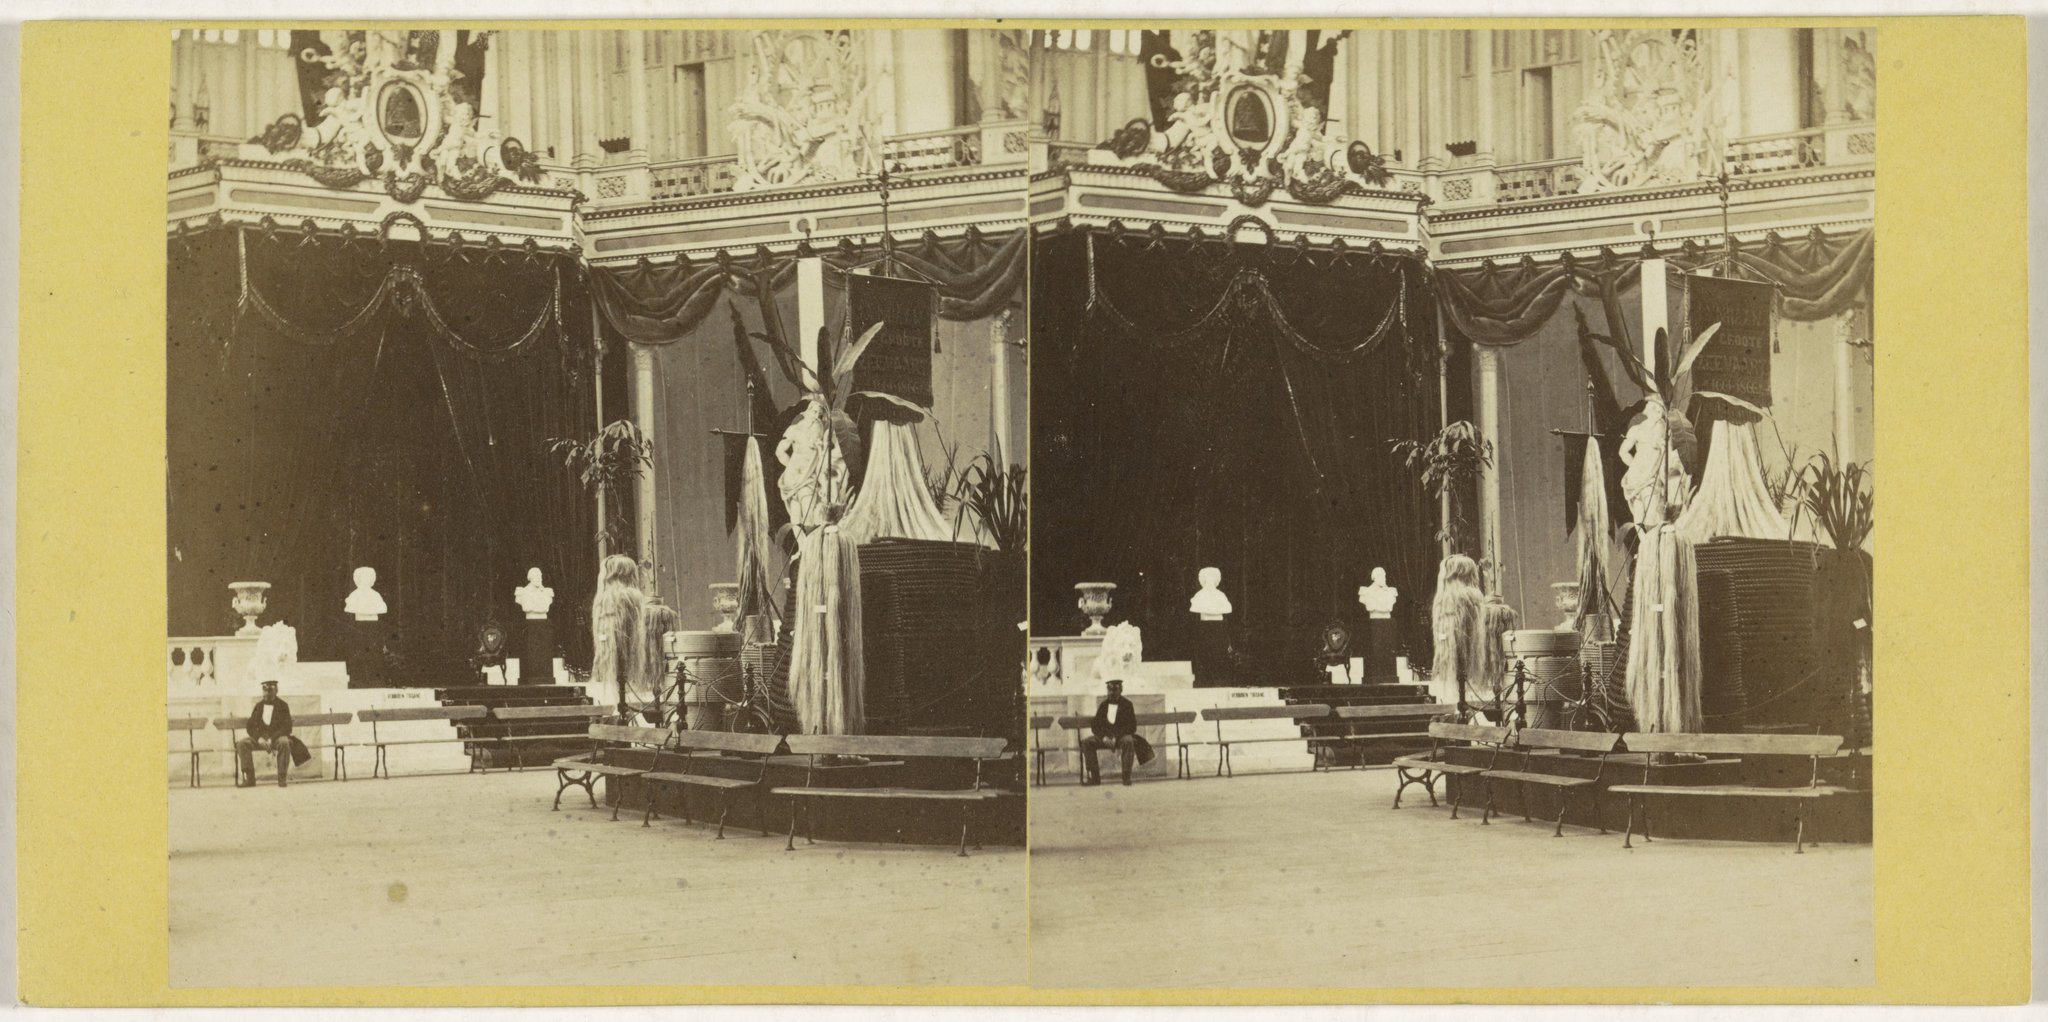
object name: stereograph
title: Bustes en andere objecten bij de Tentoonstelling voor Nationale Nijverheid en Kunst in het Paleis voor Volksvlijt, Amsterdam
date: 1866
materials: cardboard, paper, photographic support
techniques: albumen print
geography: amsterdam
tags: amsterdam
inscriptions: label: ‘Boek & Kunsthandel Jan D. Brouwer, Kalverstraat E, Nº 37 Amsterdam.’, stamp: ‘JDB’